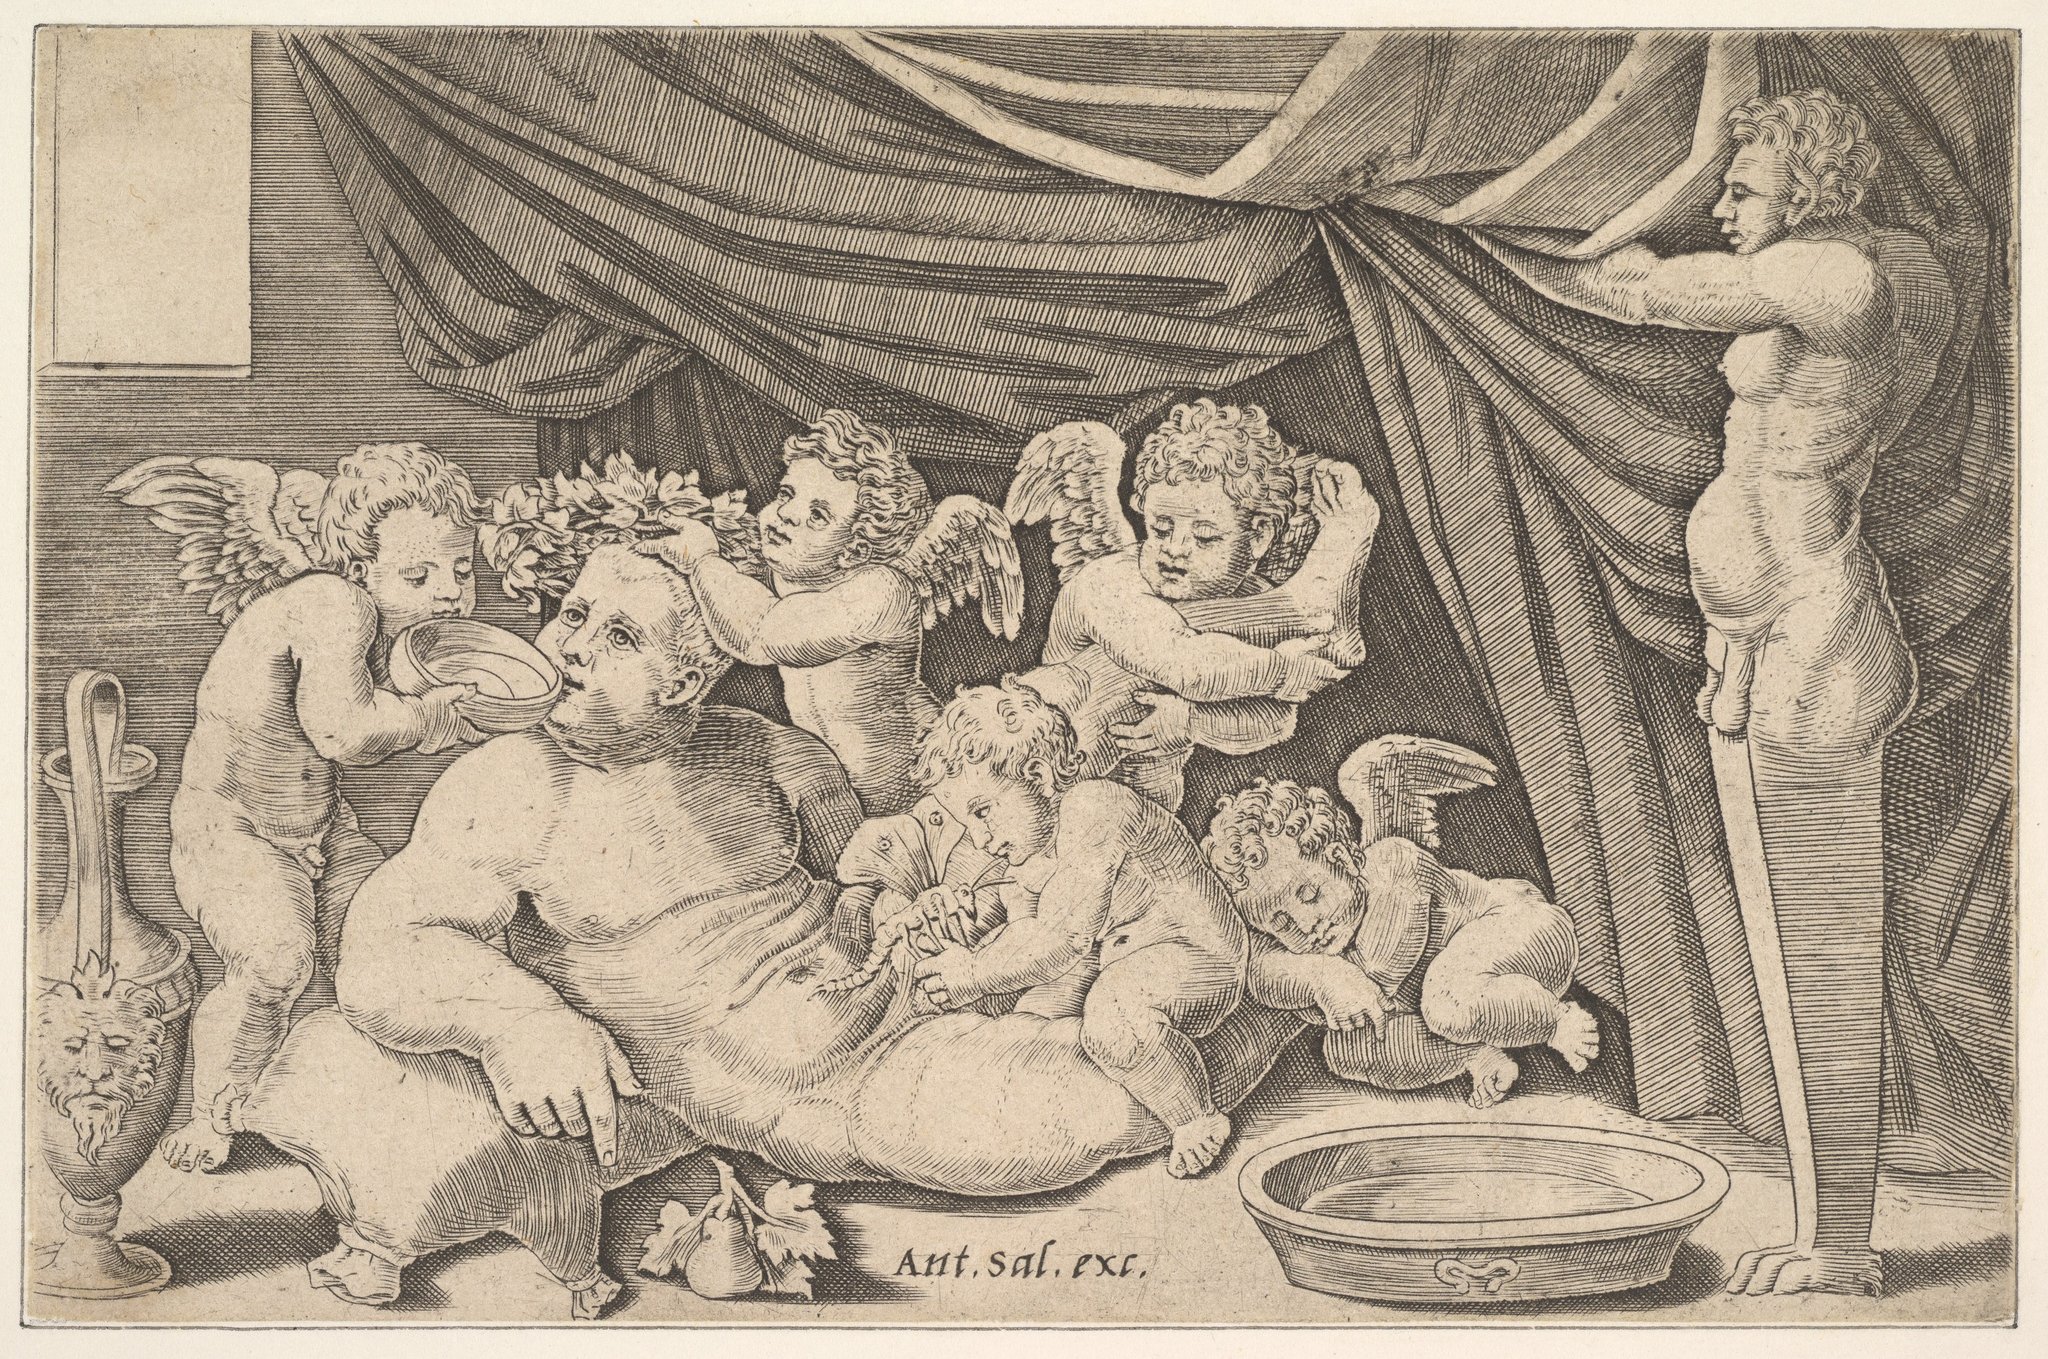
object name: print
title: Bacchus surrounded by Putti, a statue of Priapus at right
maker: master of the die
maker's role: artist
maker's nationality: italian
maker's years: 1525-1560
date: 1530-1560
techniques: engraving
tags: putti,bacchus,butterflies,drinking